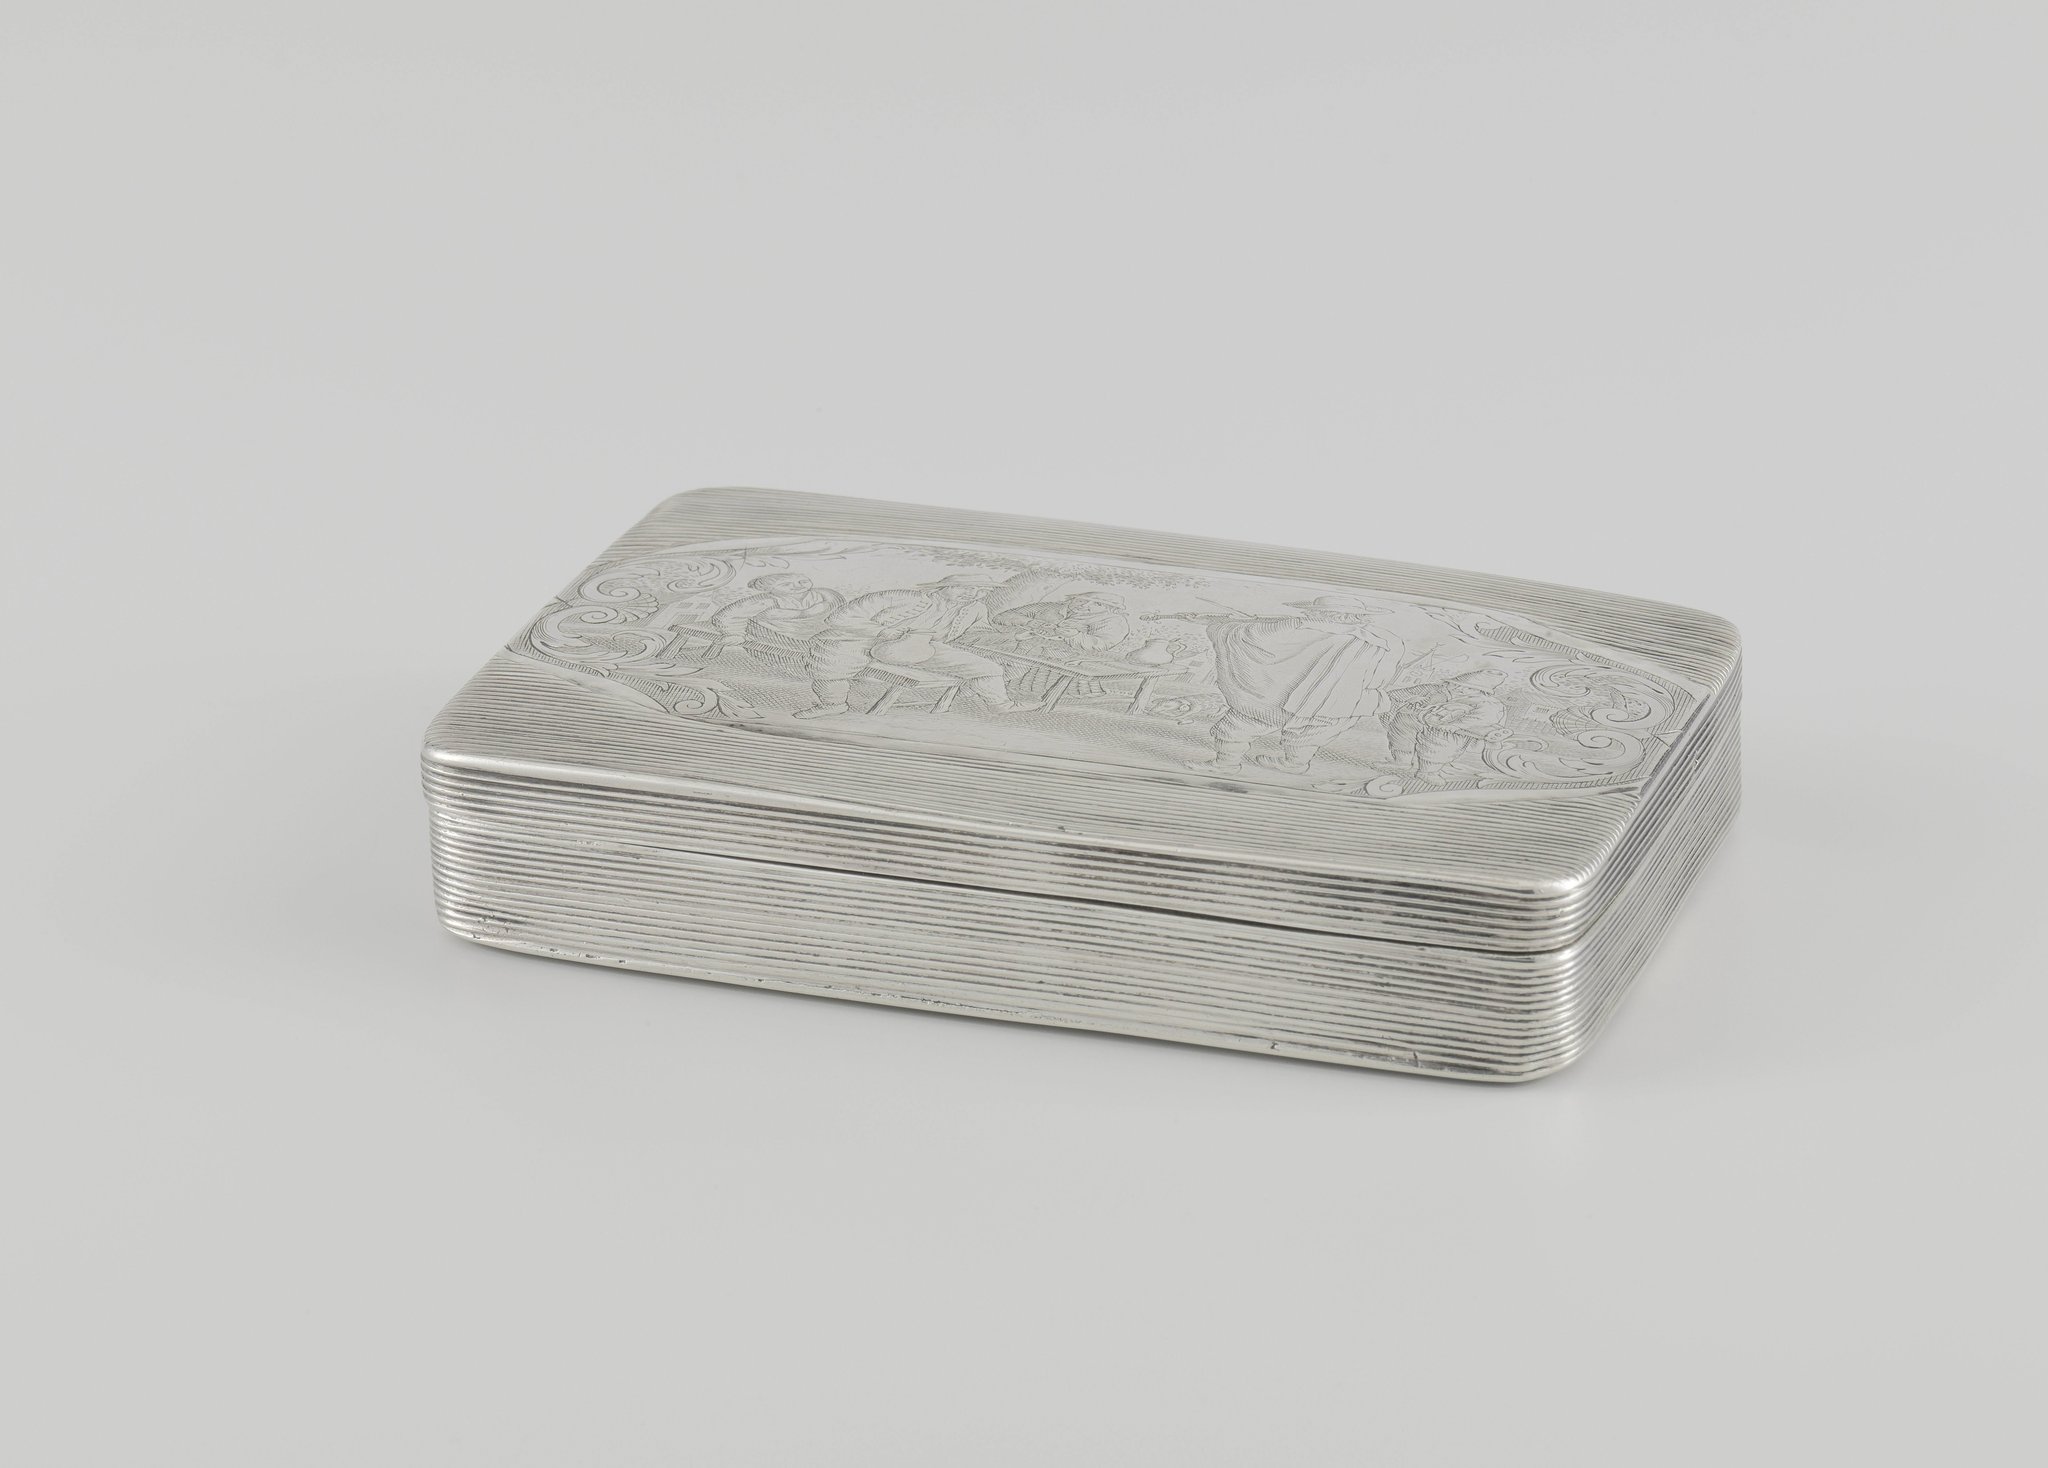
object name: tobacco box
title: Boer en boerinnen onder boom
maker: leendert verbeek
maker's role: silversmith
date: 1700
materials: silver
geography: netherlands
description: Tabaksdoos van zilver. Gegraveerd met een boer en boerinnen die onder een boom zitten.